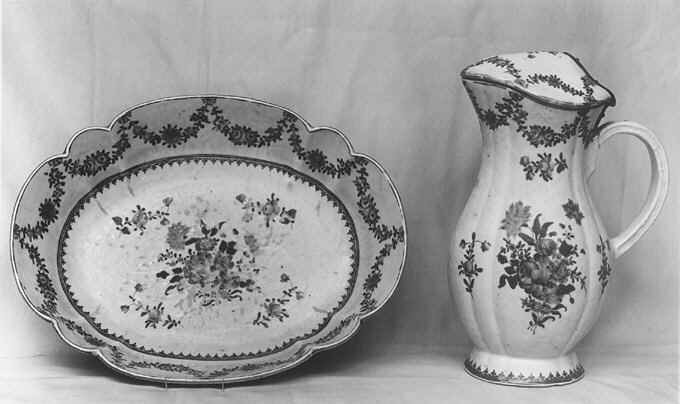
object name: ewer and basin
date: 1765-1775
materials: hard paste porcelain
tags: flowers